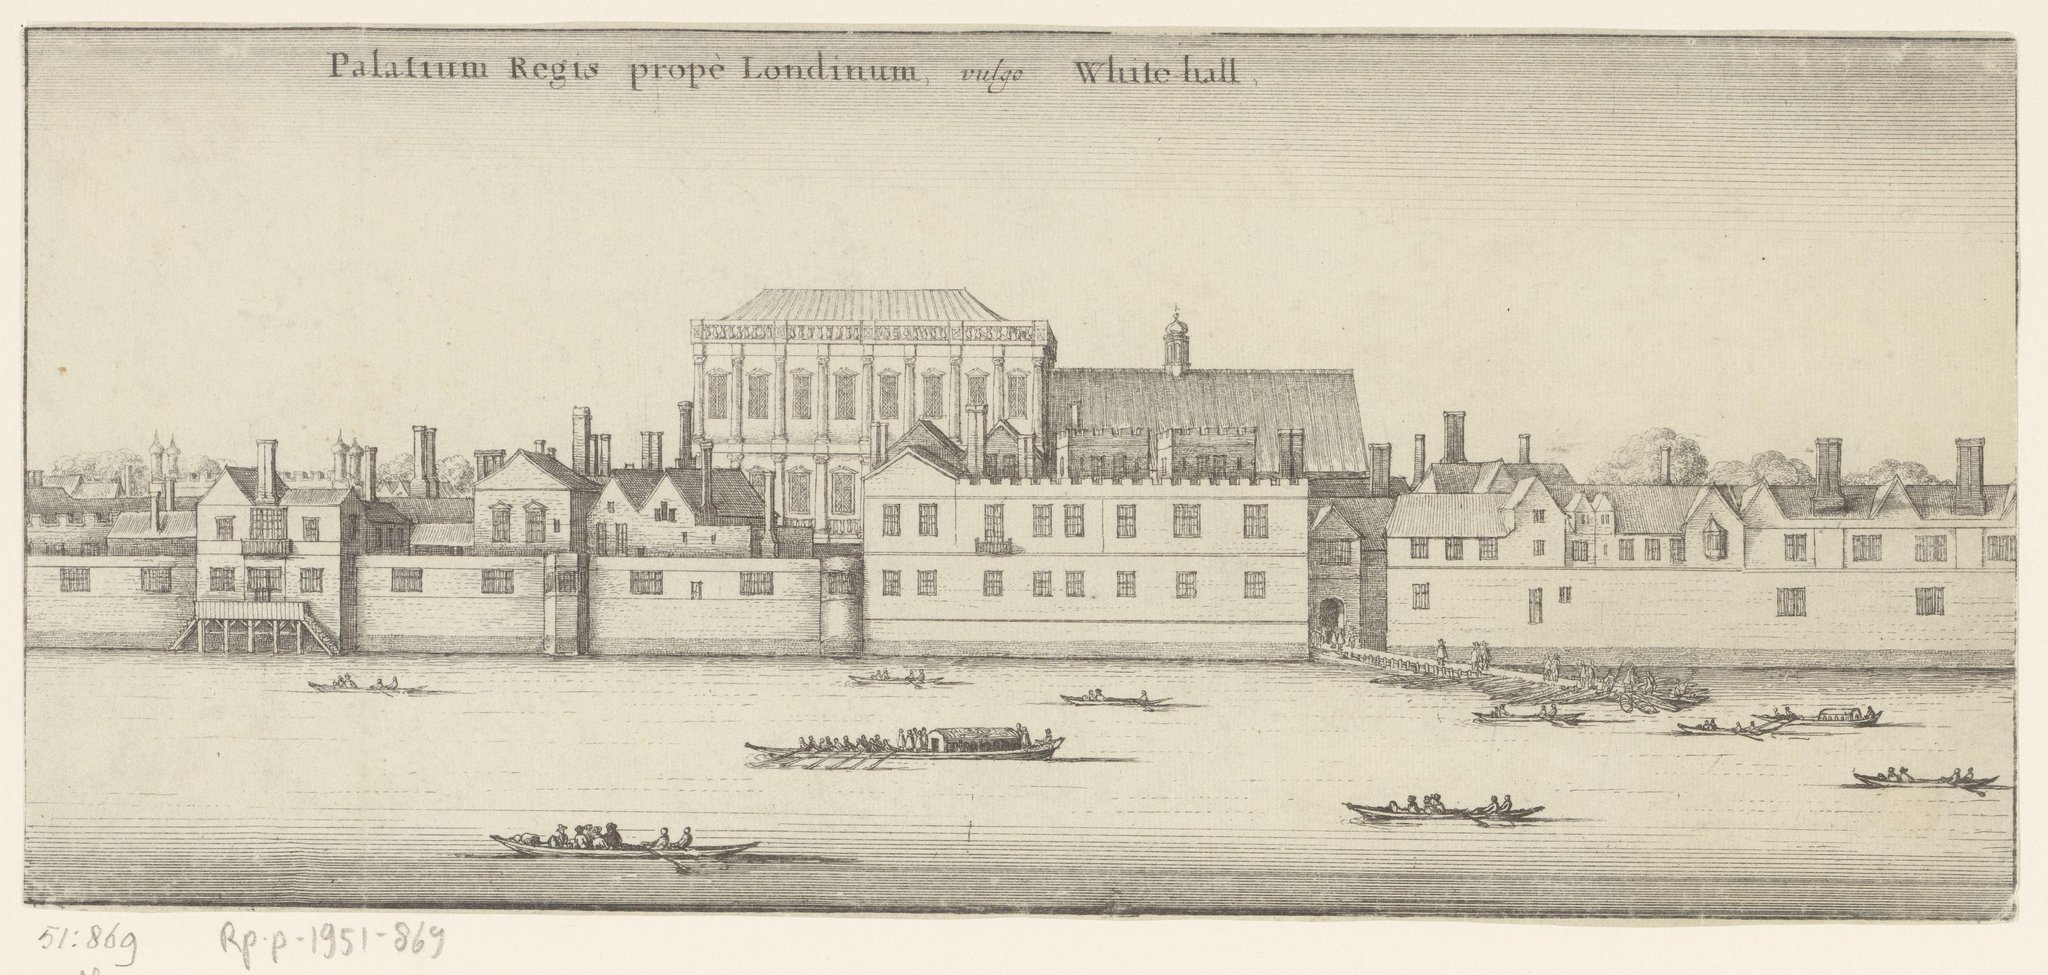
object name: print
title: Whitehall te Londen, gezien vanaf de Theems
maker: wenceslaus hollar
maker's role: draughtsman, print maker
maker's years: 1607-1677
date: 1647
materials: paper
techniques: etching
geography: antwerp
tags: city-view, and landscape with man-made constructions, river, thames